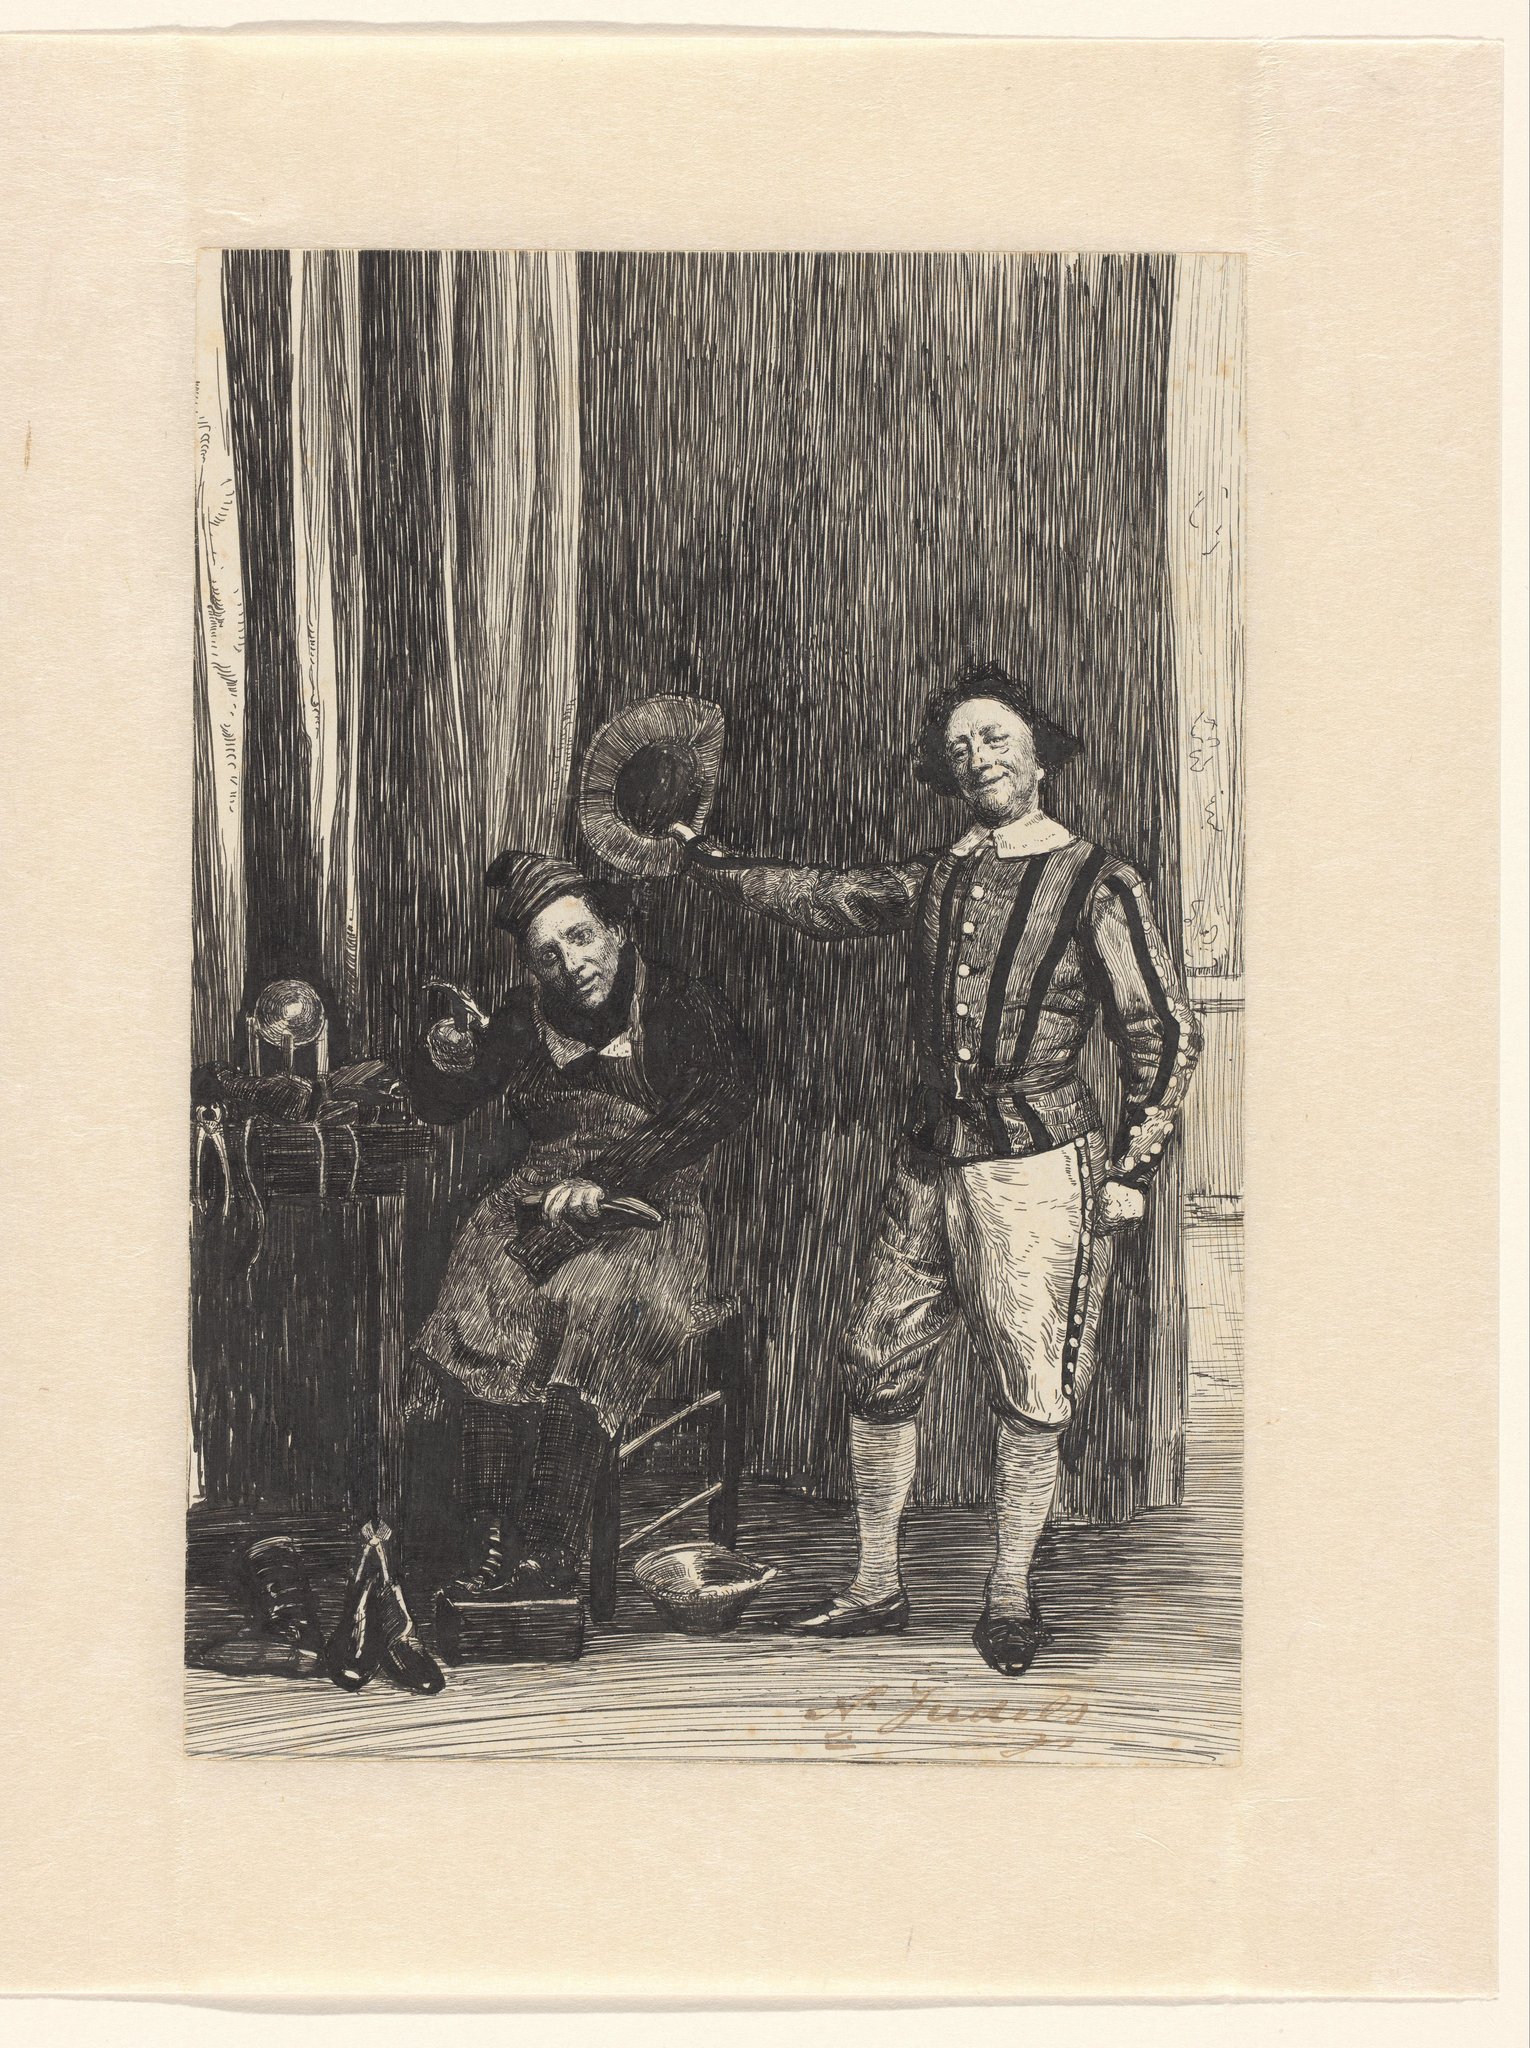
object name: drawing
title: Man met hoed bij een schoenmaker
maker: n. judels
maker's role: draughtsman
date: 1800-1899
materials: ink, paper, pencil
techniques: pen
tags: arm stretched sidewards, shoe-maker, cobbler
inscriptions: collector's mark: Lugt 2233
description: De man heeft een hoed in zijn uitgestrekte hand.